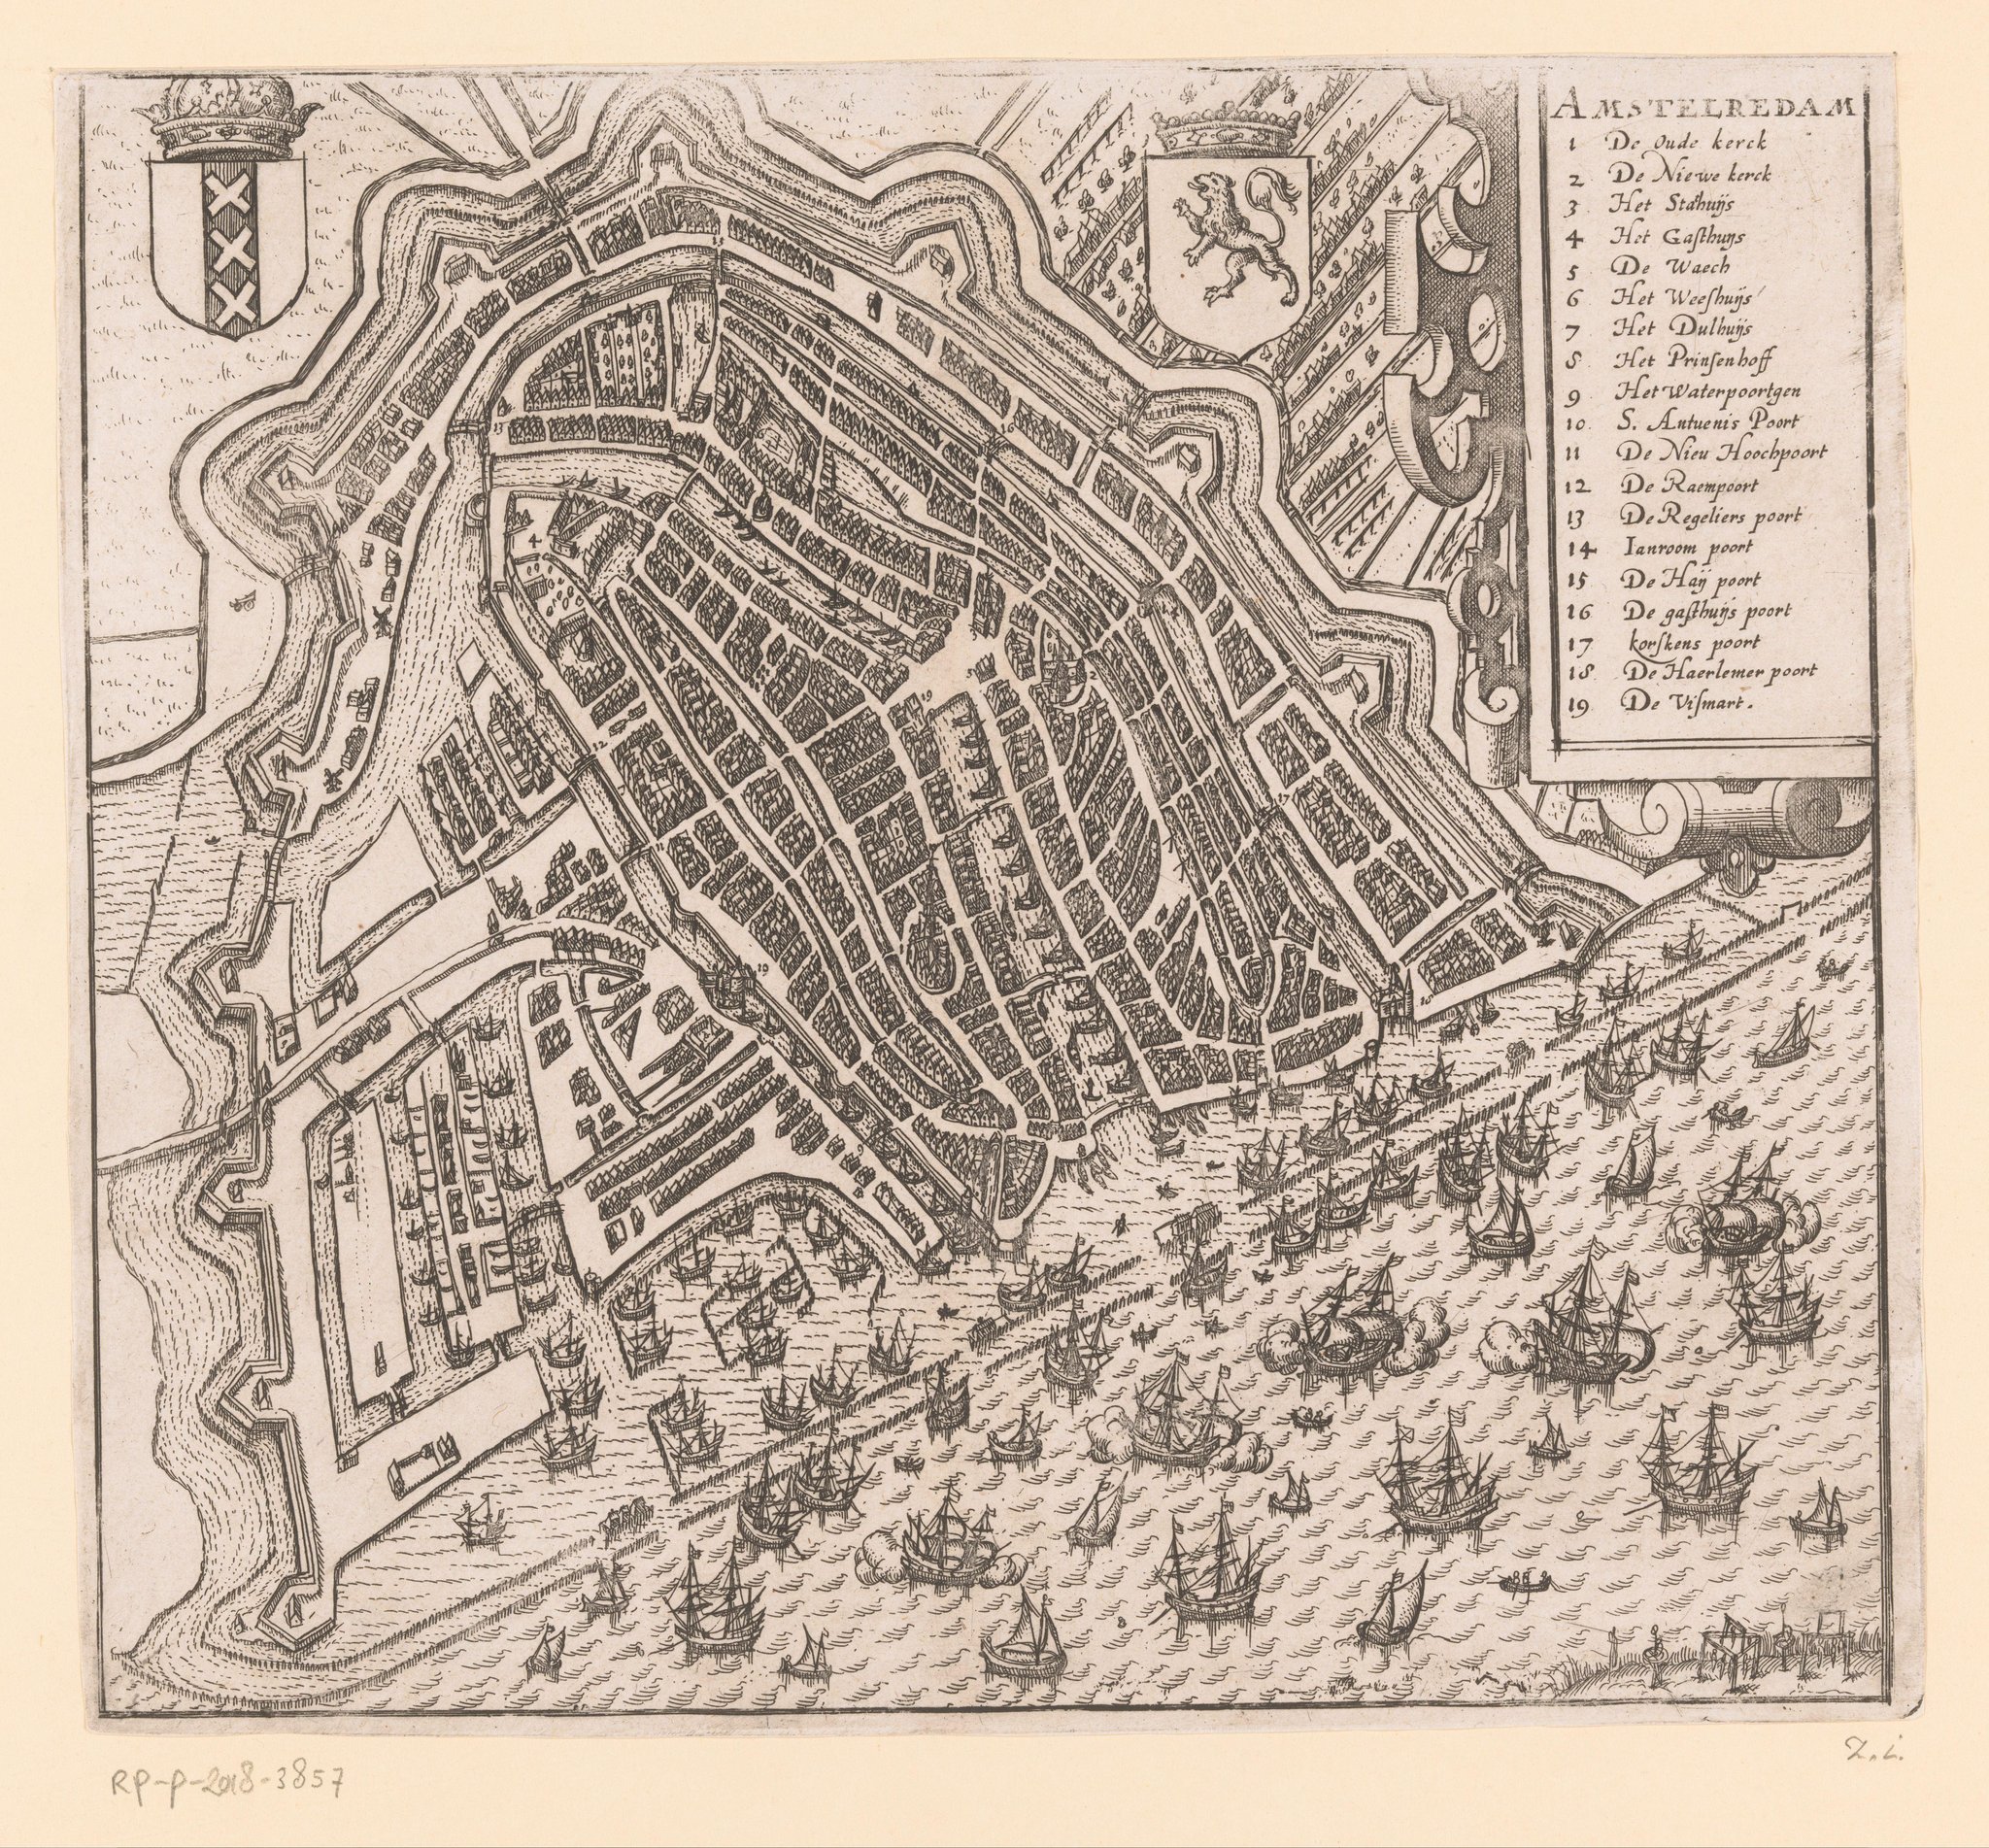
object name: area plan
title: Plattegrond van Amsterdam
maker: Anonymous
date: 1600-1650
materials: paper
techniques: etching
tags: maps of cities, amsterdam